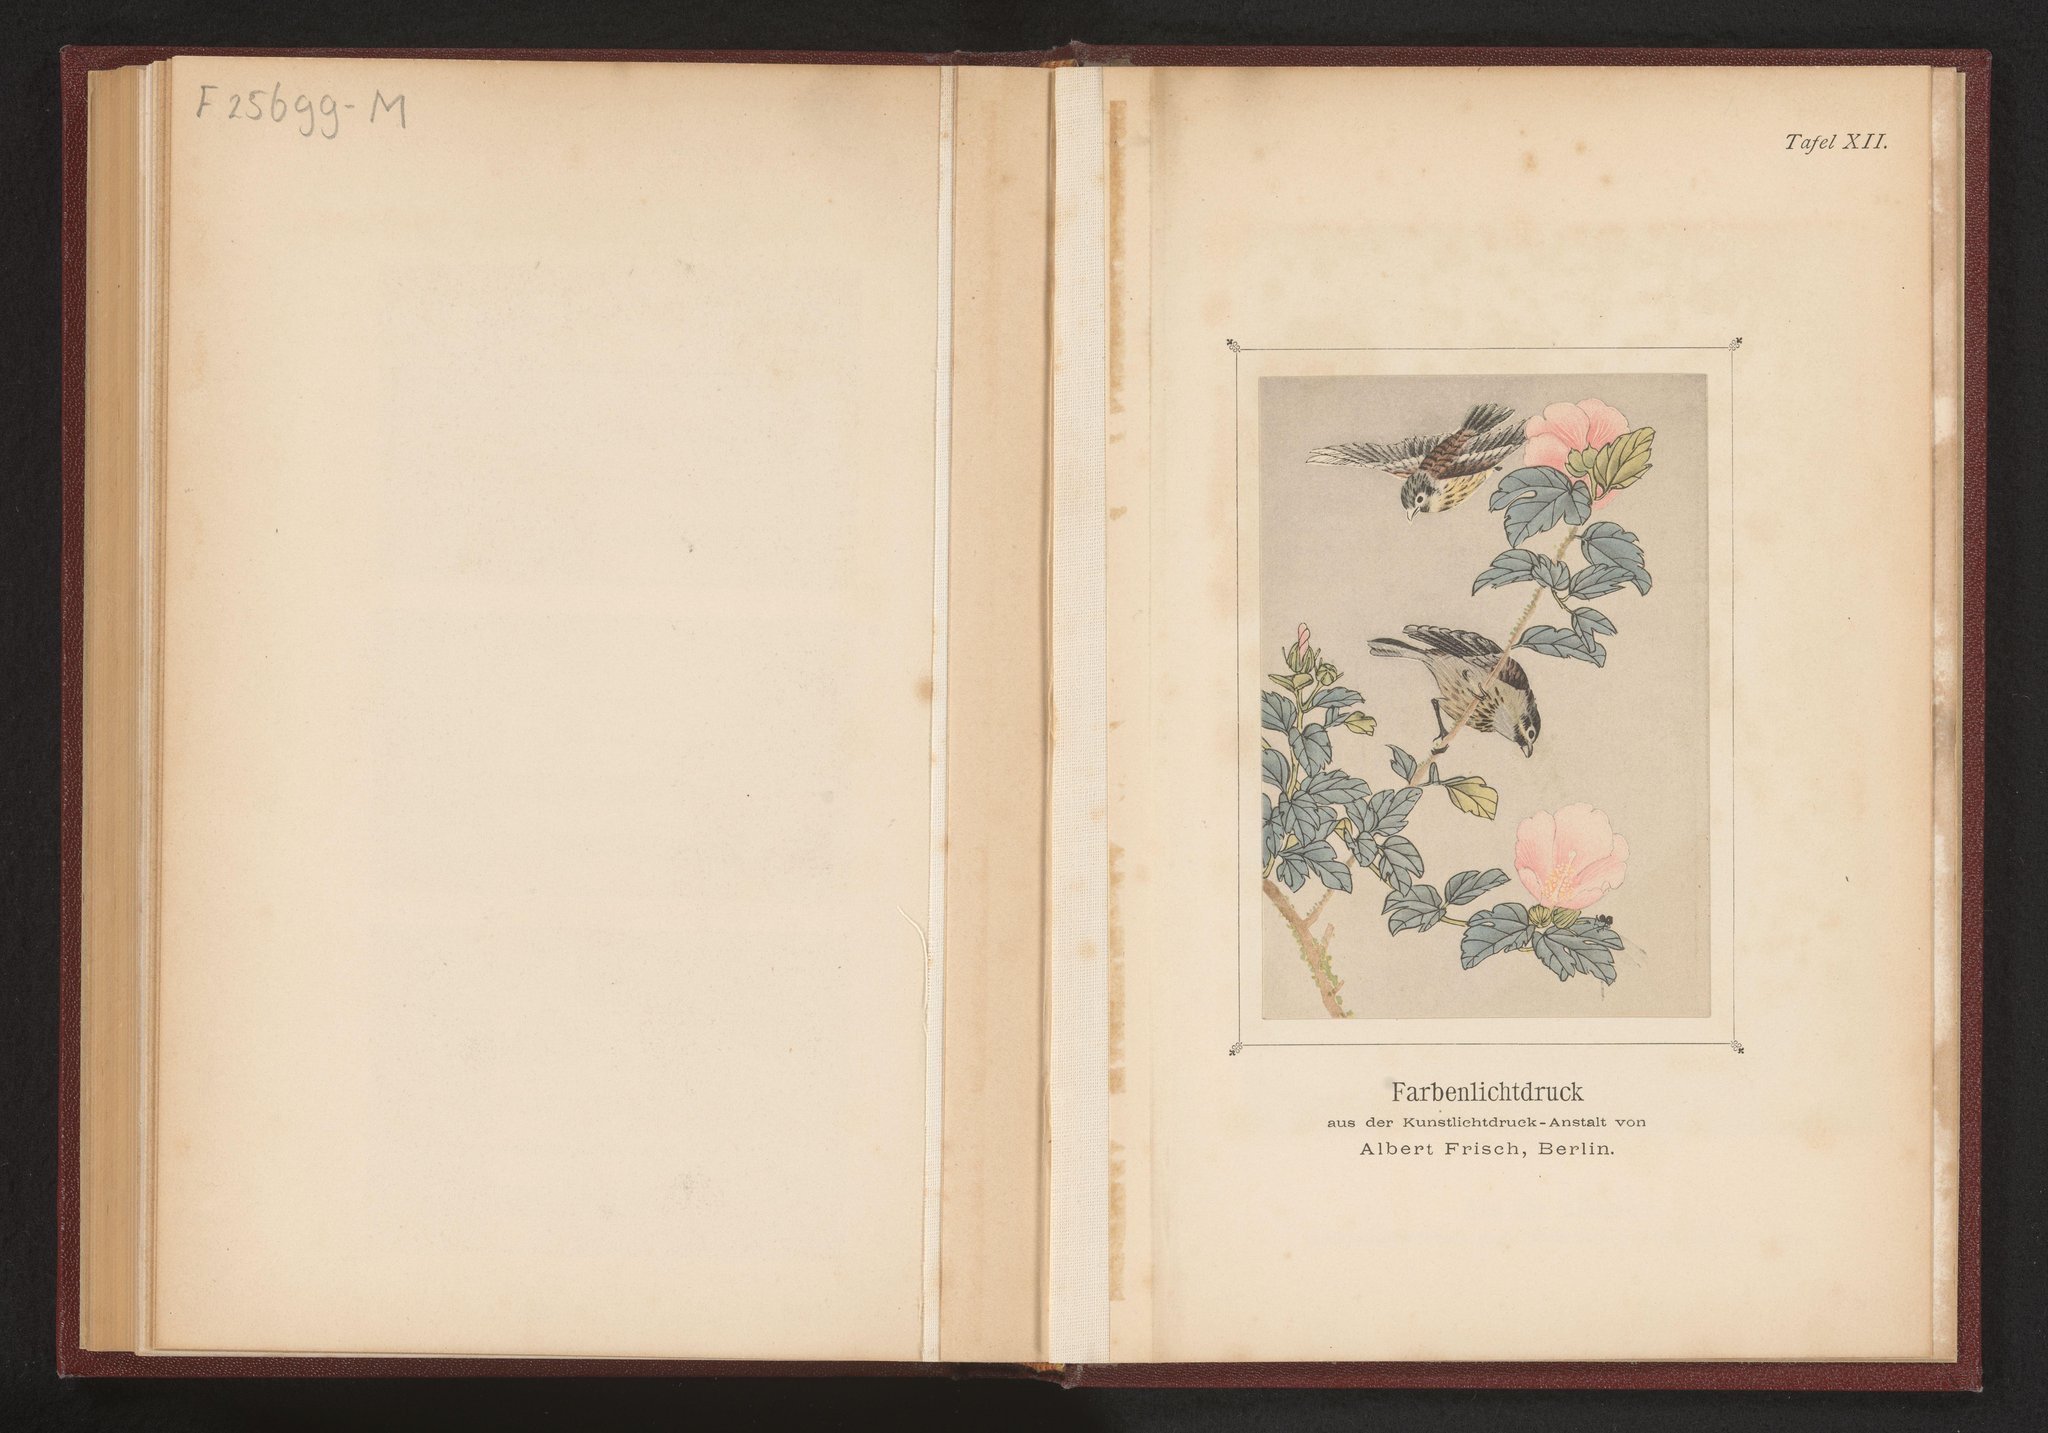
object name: photomechanical print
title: Twee vogels op een bloeiende tak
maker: albert frisch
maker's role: printer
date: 1885-1890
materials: paper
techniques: collotype process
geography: berlin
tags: birds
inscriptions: number: ‘Tafel XII.’, inscription: ‘Farbenlichtdruck/ aus der Kunstlichtdruck-Anstalt von/ Albert Frisch, Berlin.’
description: Prent op tweeëntwintigste ongenummerde pagina na pagina 351.